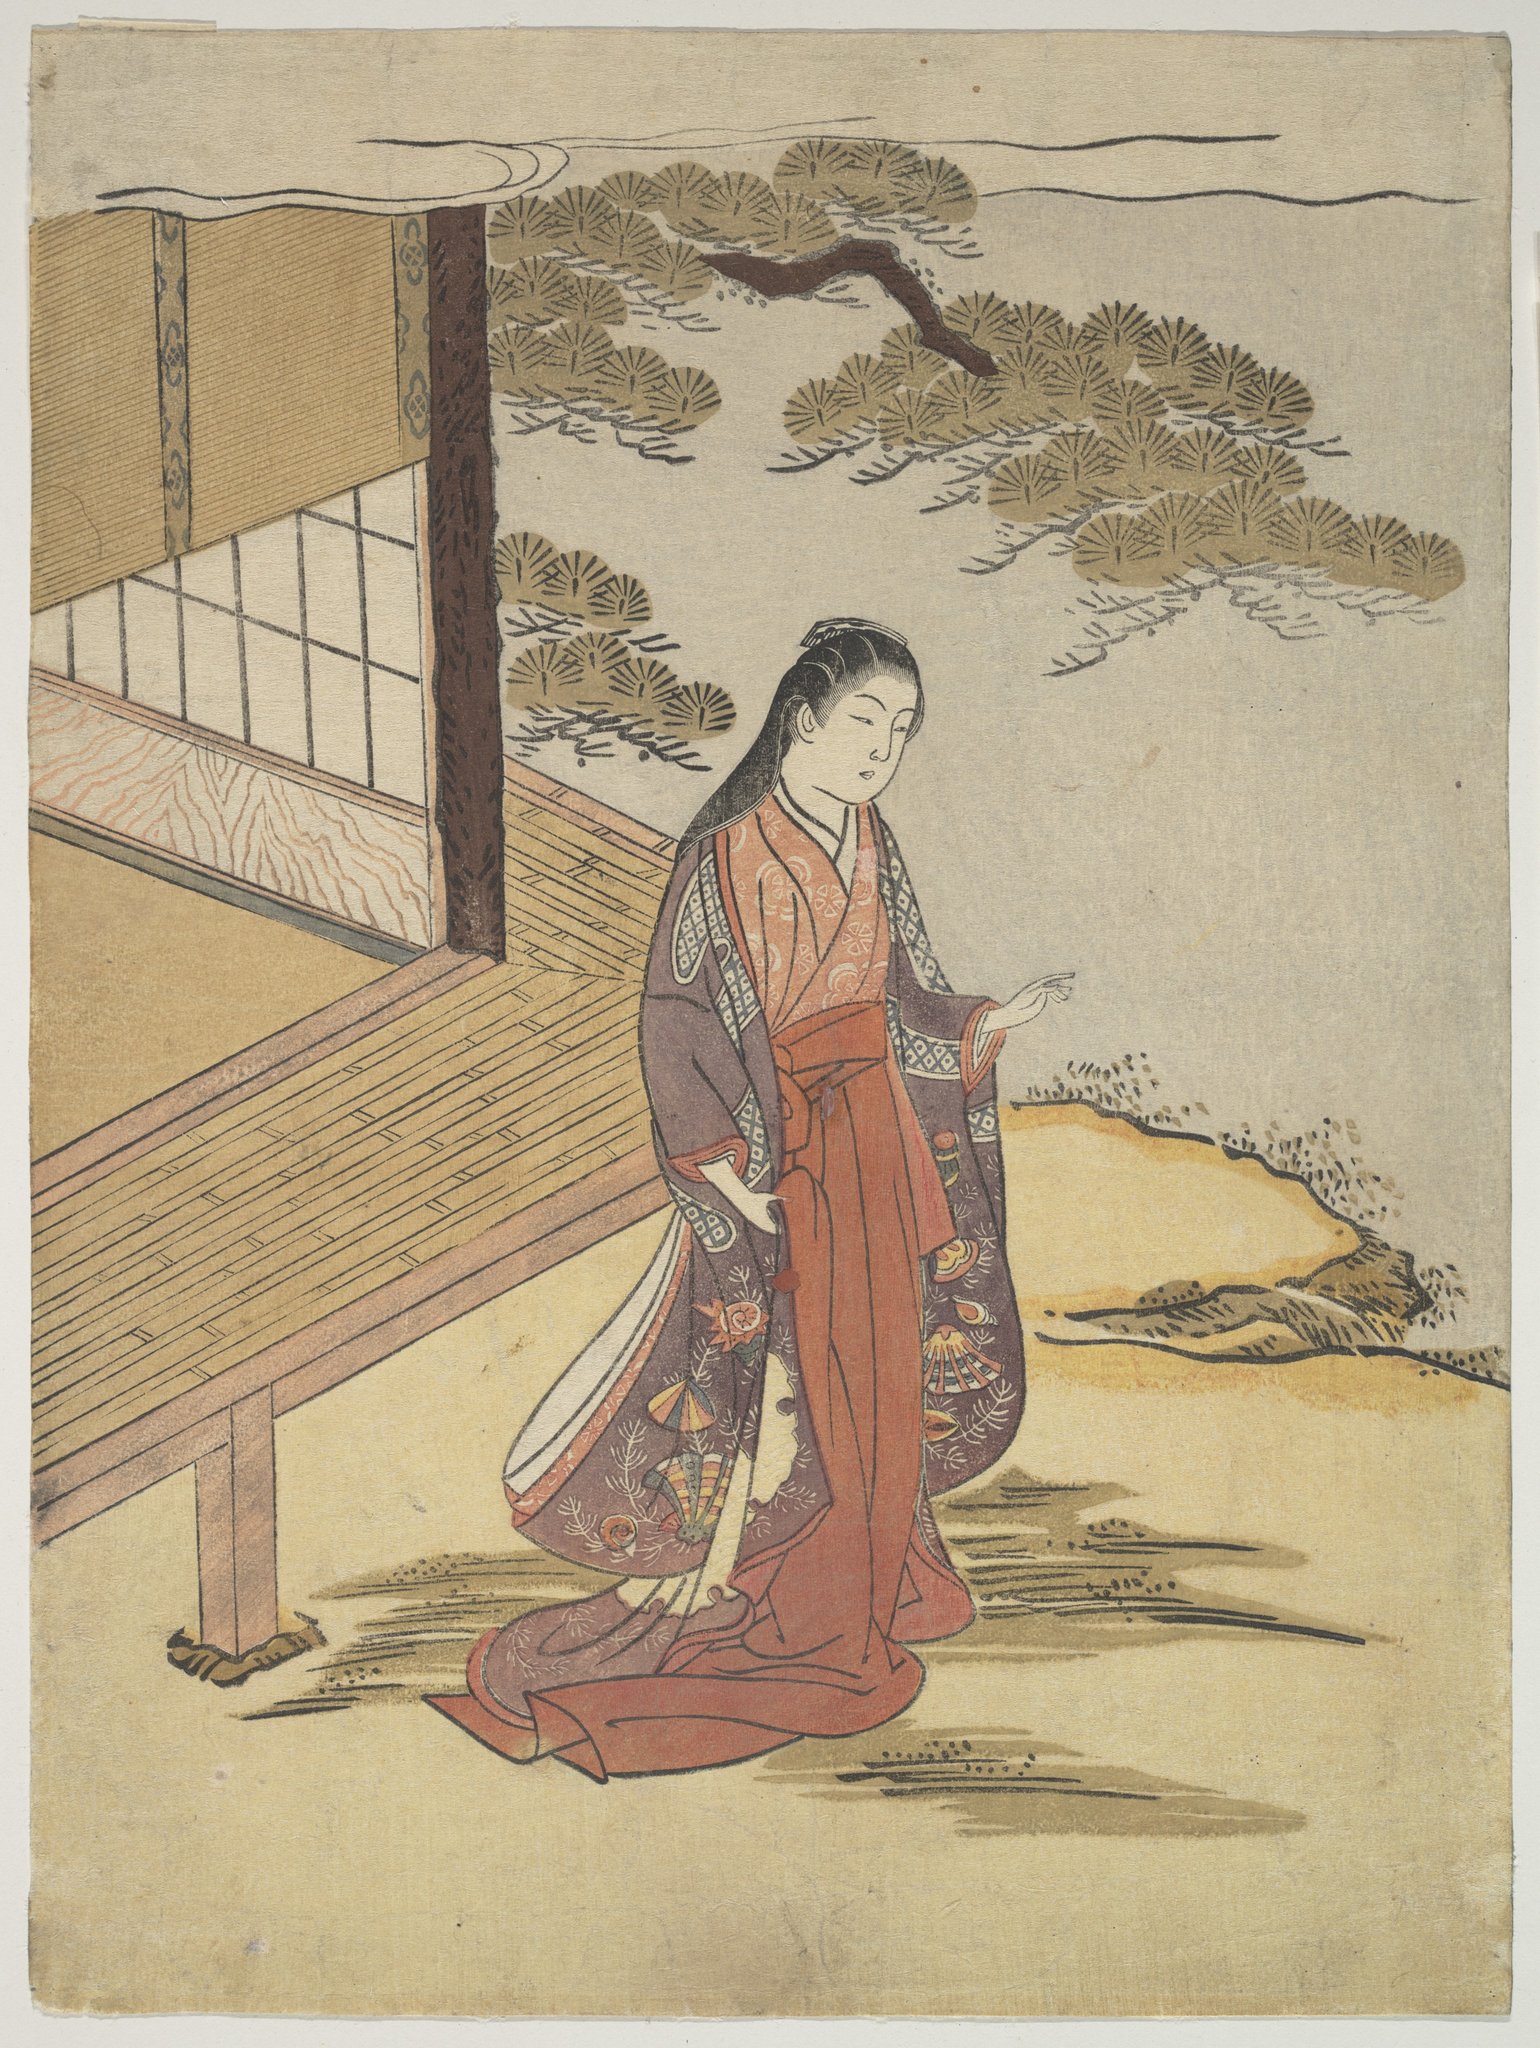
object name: print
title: Lady Komachi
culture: japanese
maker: suzuki harunobu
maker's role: artist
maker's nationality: japanese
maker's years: 1725-1770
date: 1725-1770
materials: ink, paper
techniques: woodblock print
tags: women